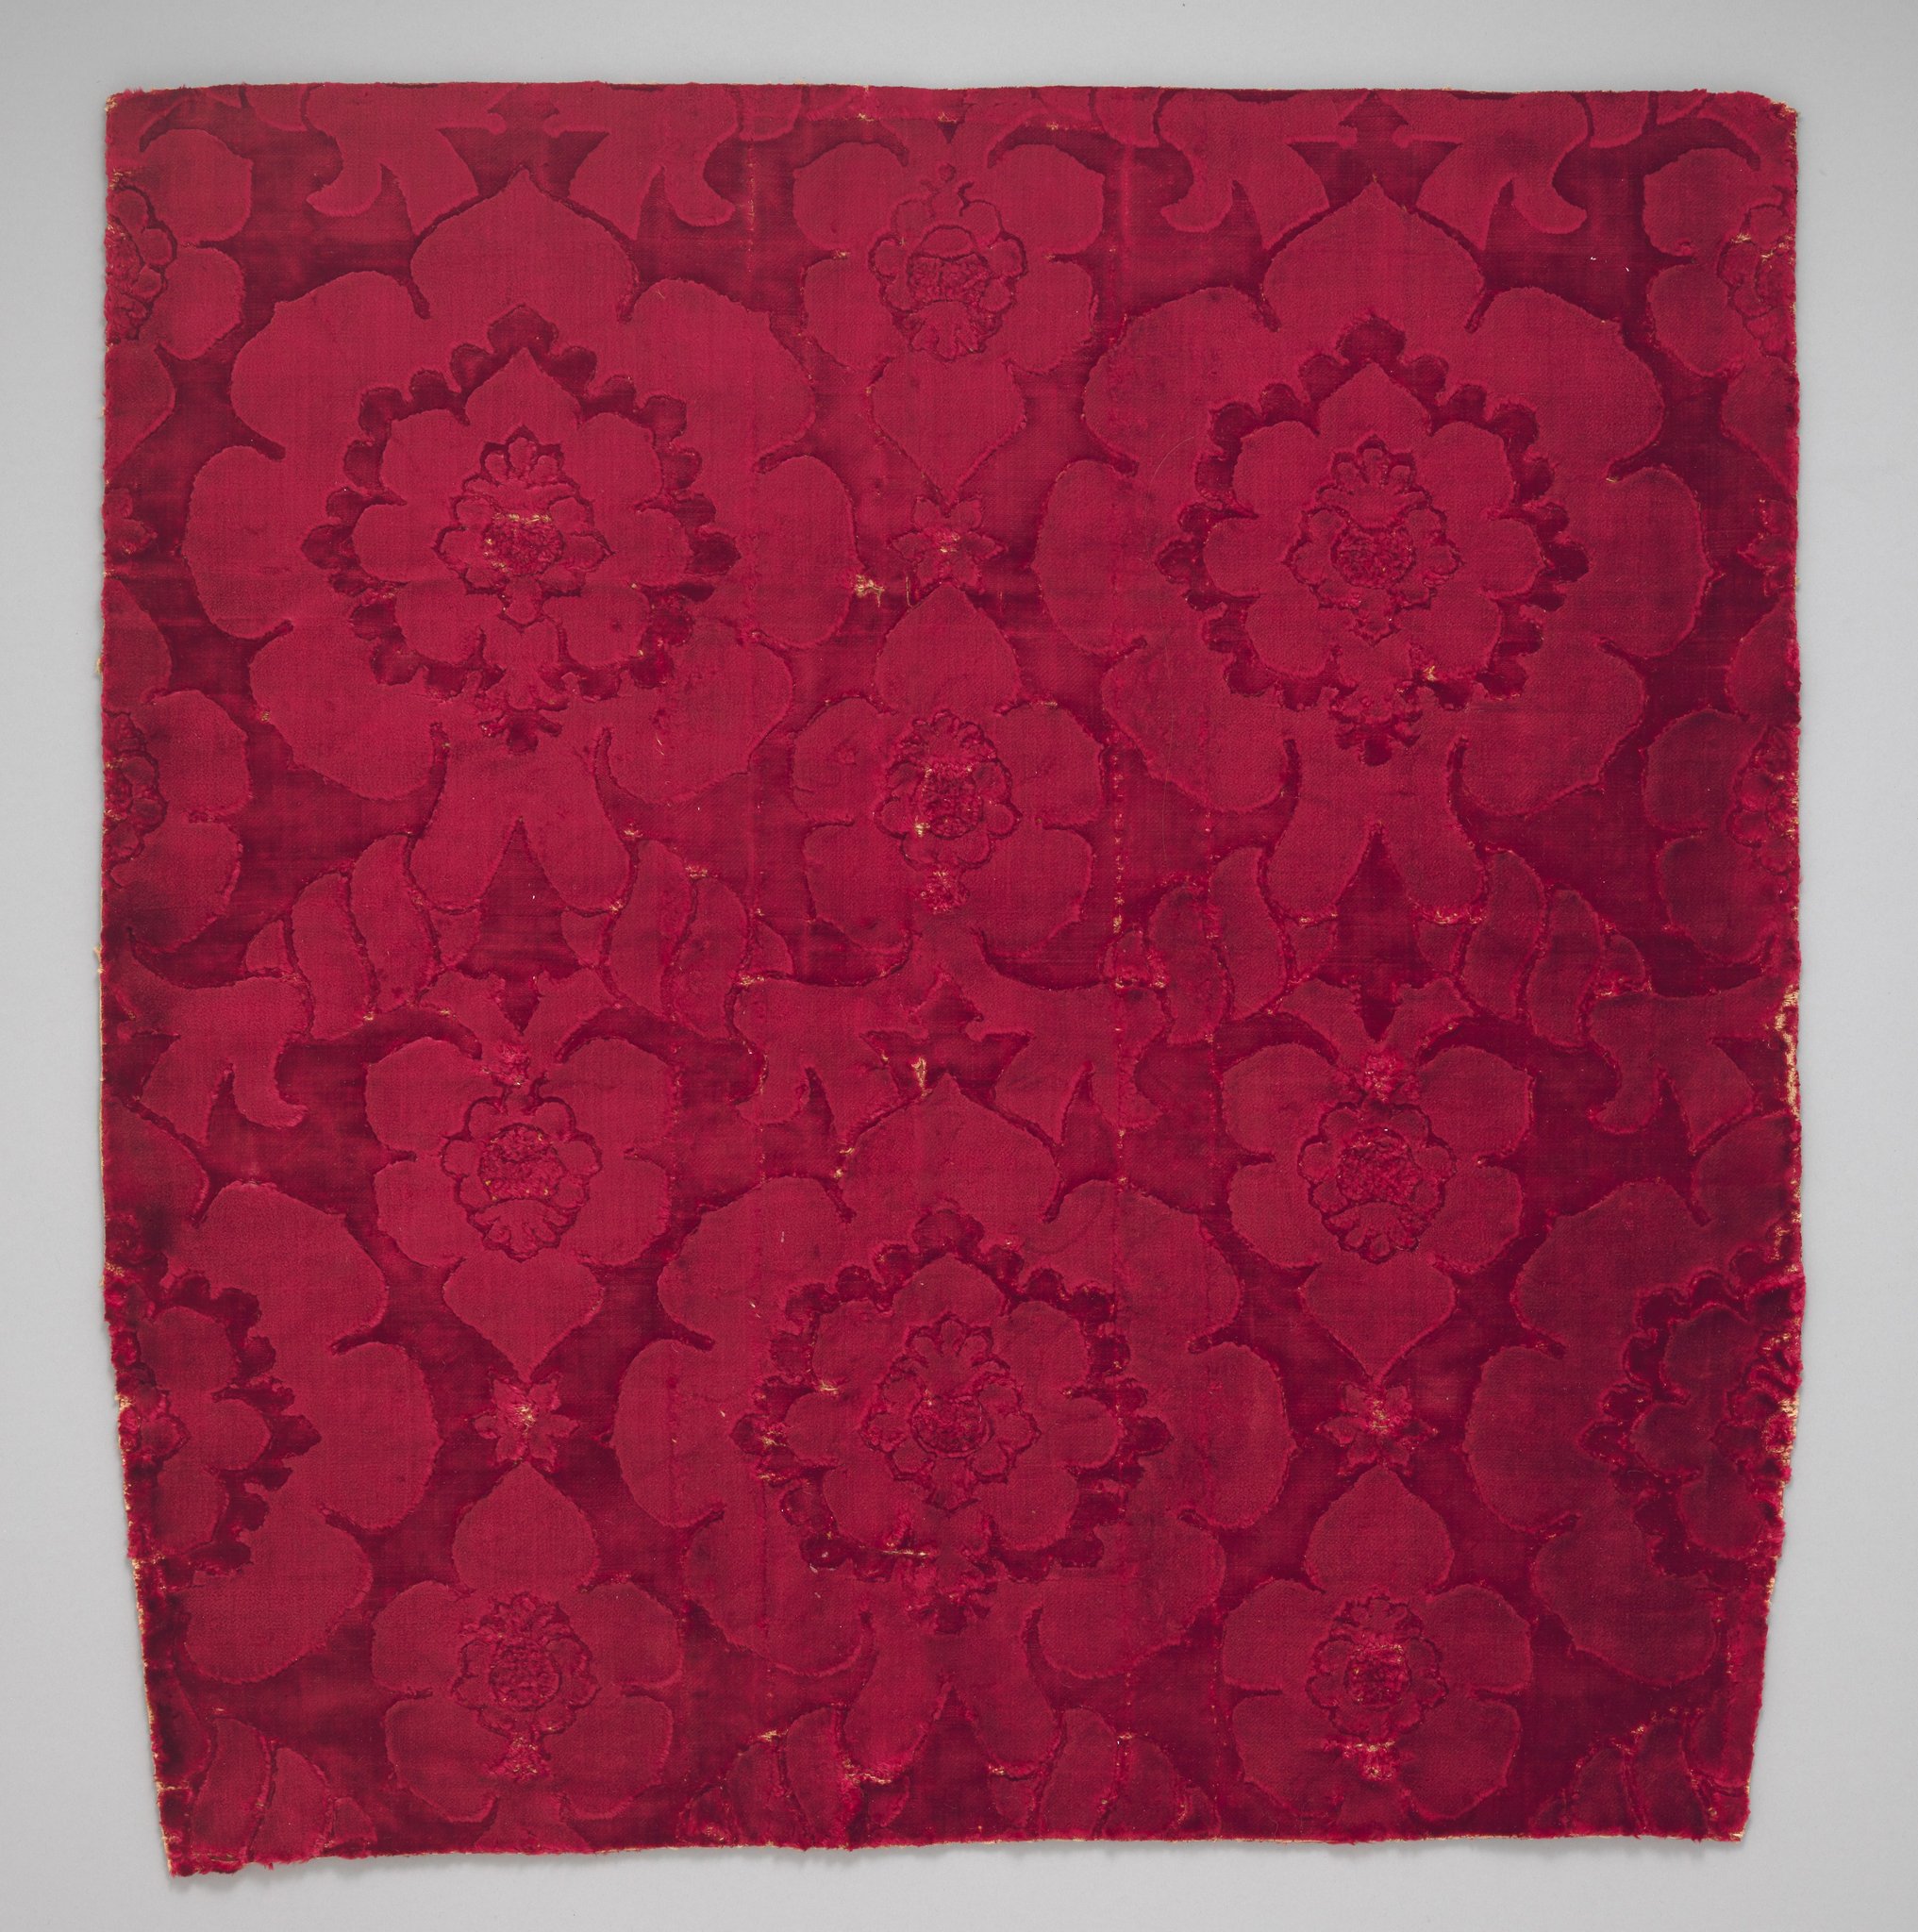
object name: piece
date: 1501-1600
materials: silk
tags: flowers